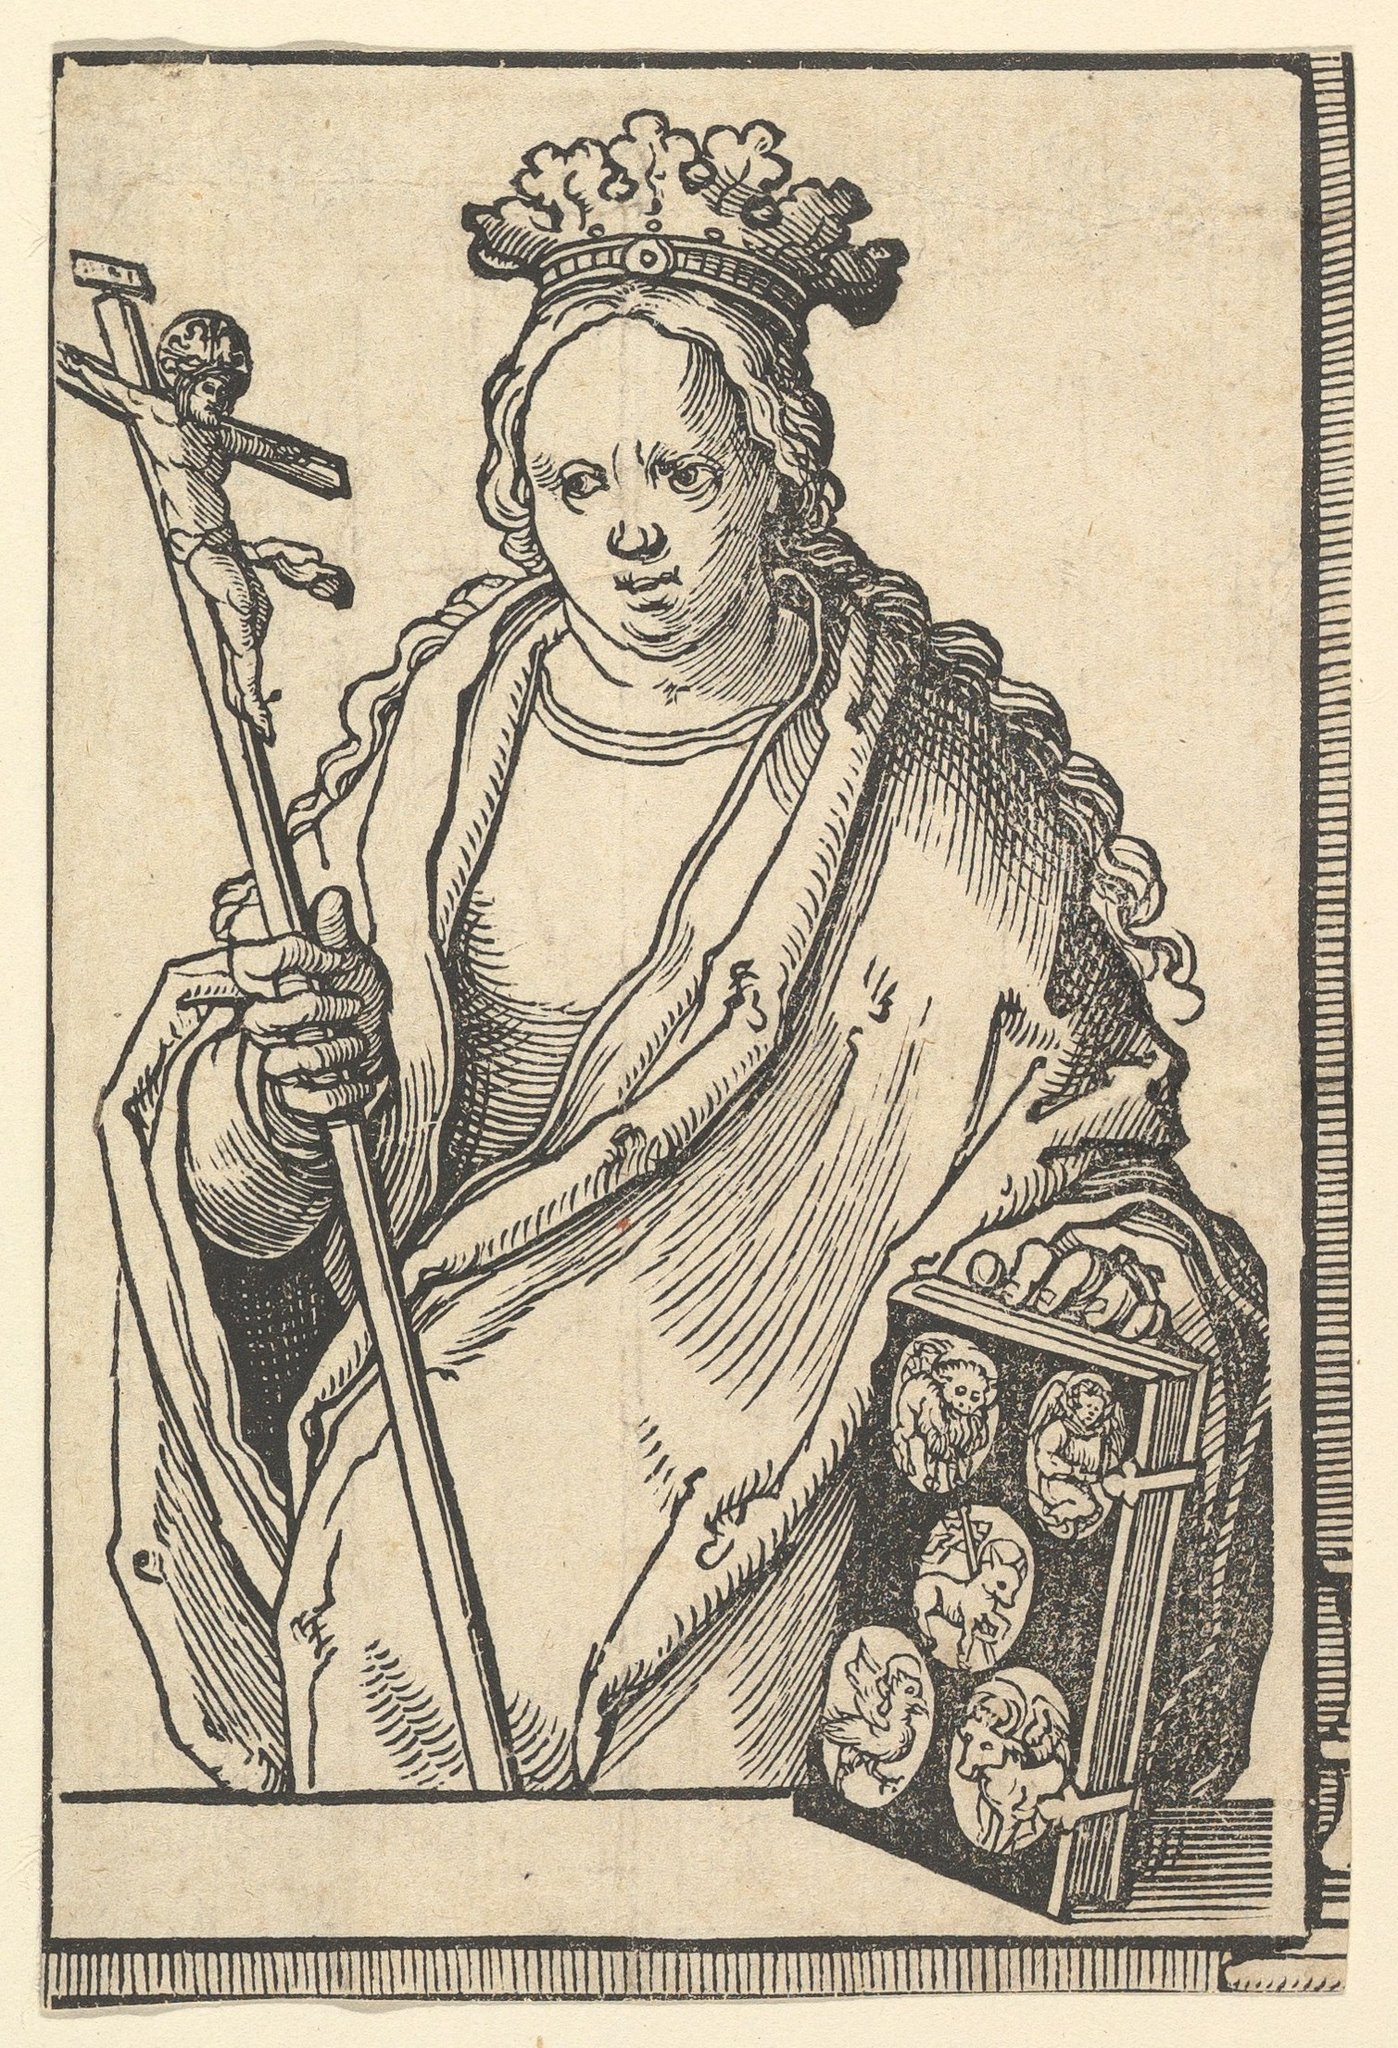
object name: print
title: Ecclesia Christi (Faith), from the series of Sibyls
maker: lucas van leyden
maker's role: artist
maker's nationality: netherlandish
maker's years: 1494-1533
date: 1530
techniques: woodcut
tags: books,sibyl,cross,crucifixion